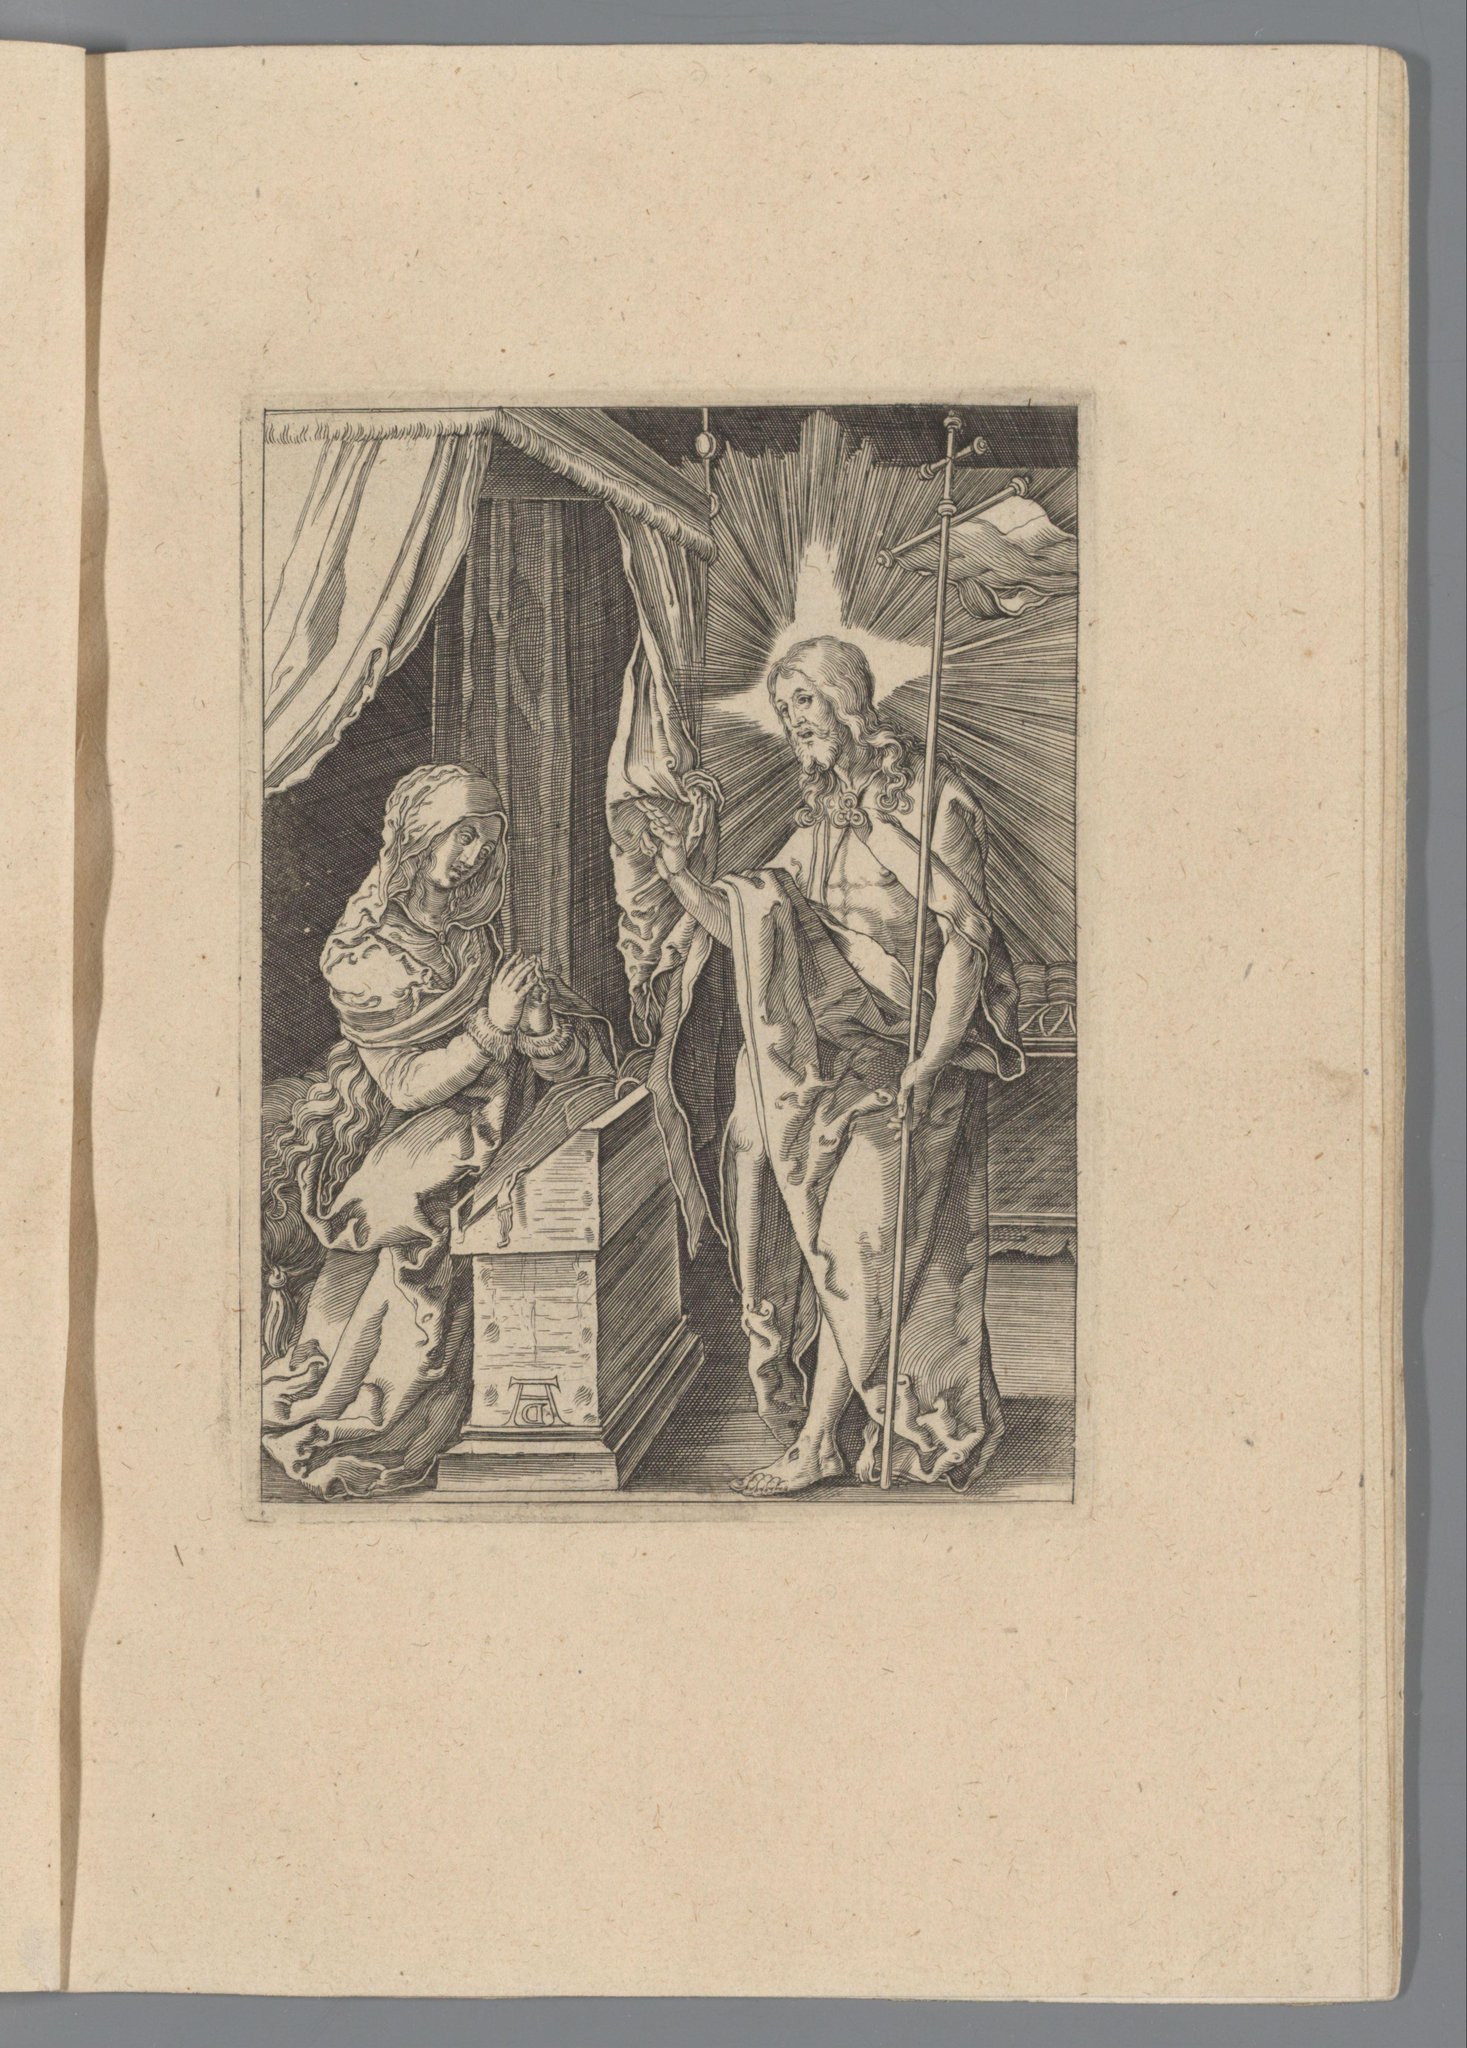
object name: print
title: Christus verschijnt aan zijn moeder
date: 1610-1620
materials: paper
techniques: engraving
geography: the hague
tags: christ, perhaps dressed as a pilgrim, appearing to his mother, who is usually shown praying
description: De opgestane Christus groet zijn moeder Maria, die geknield voor een lezenaar zit. Prent maakt deel uit van een album.